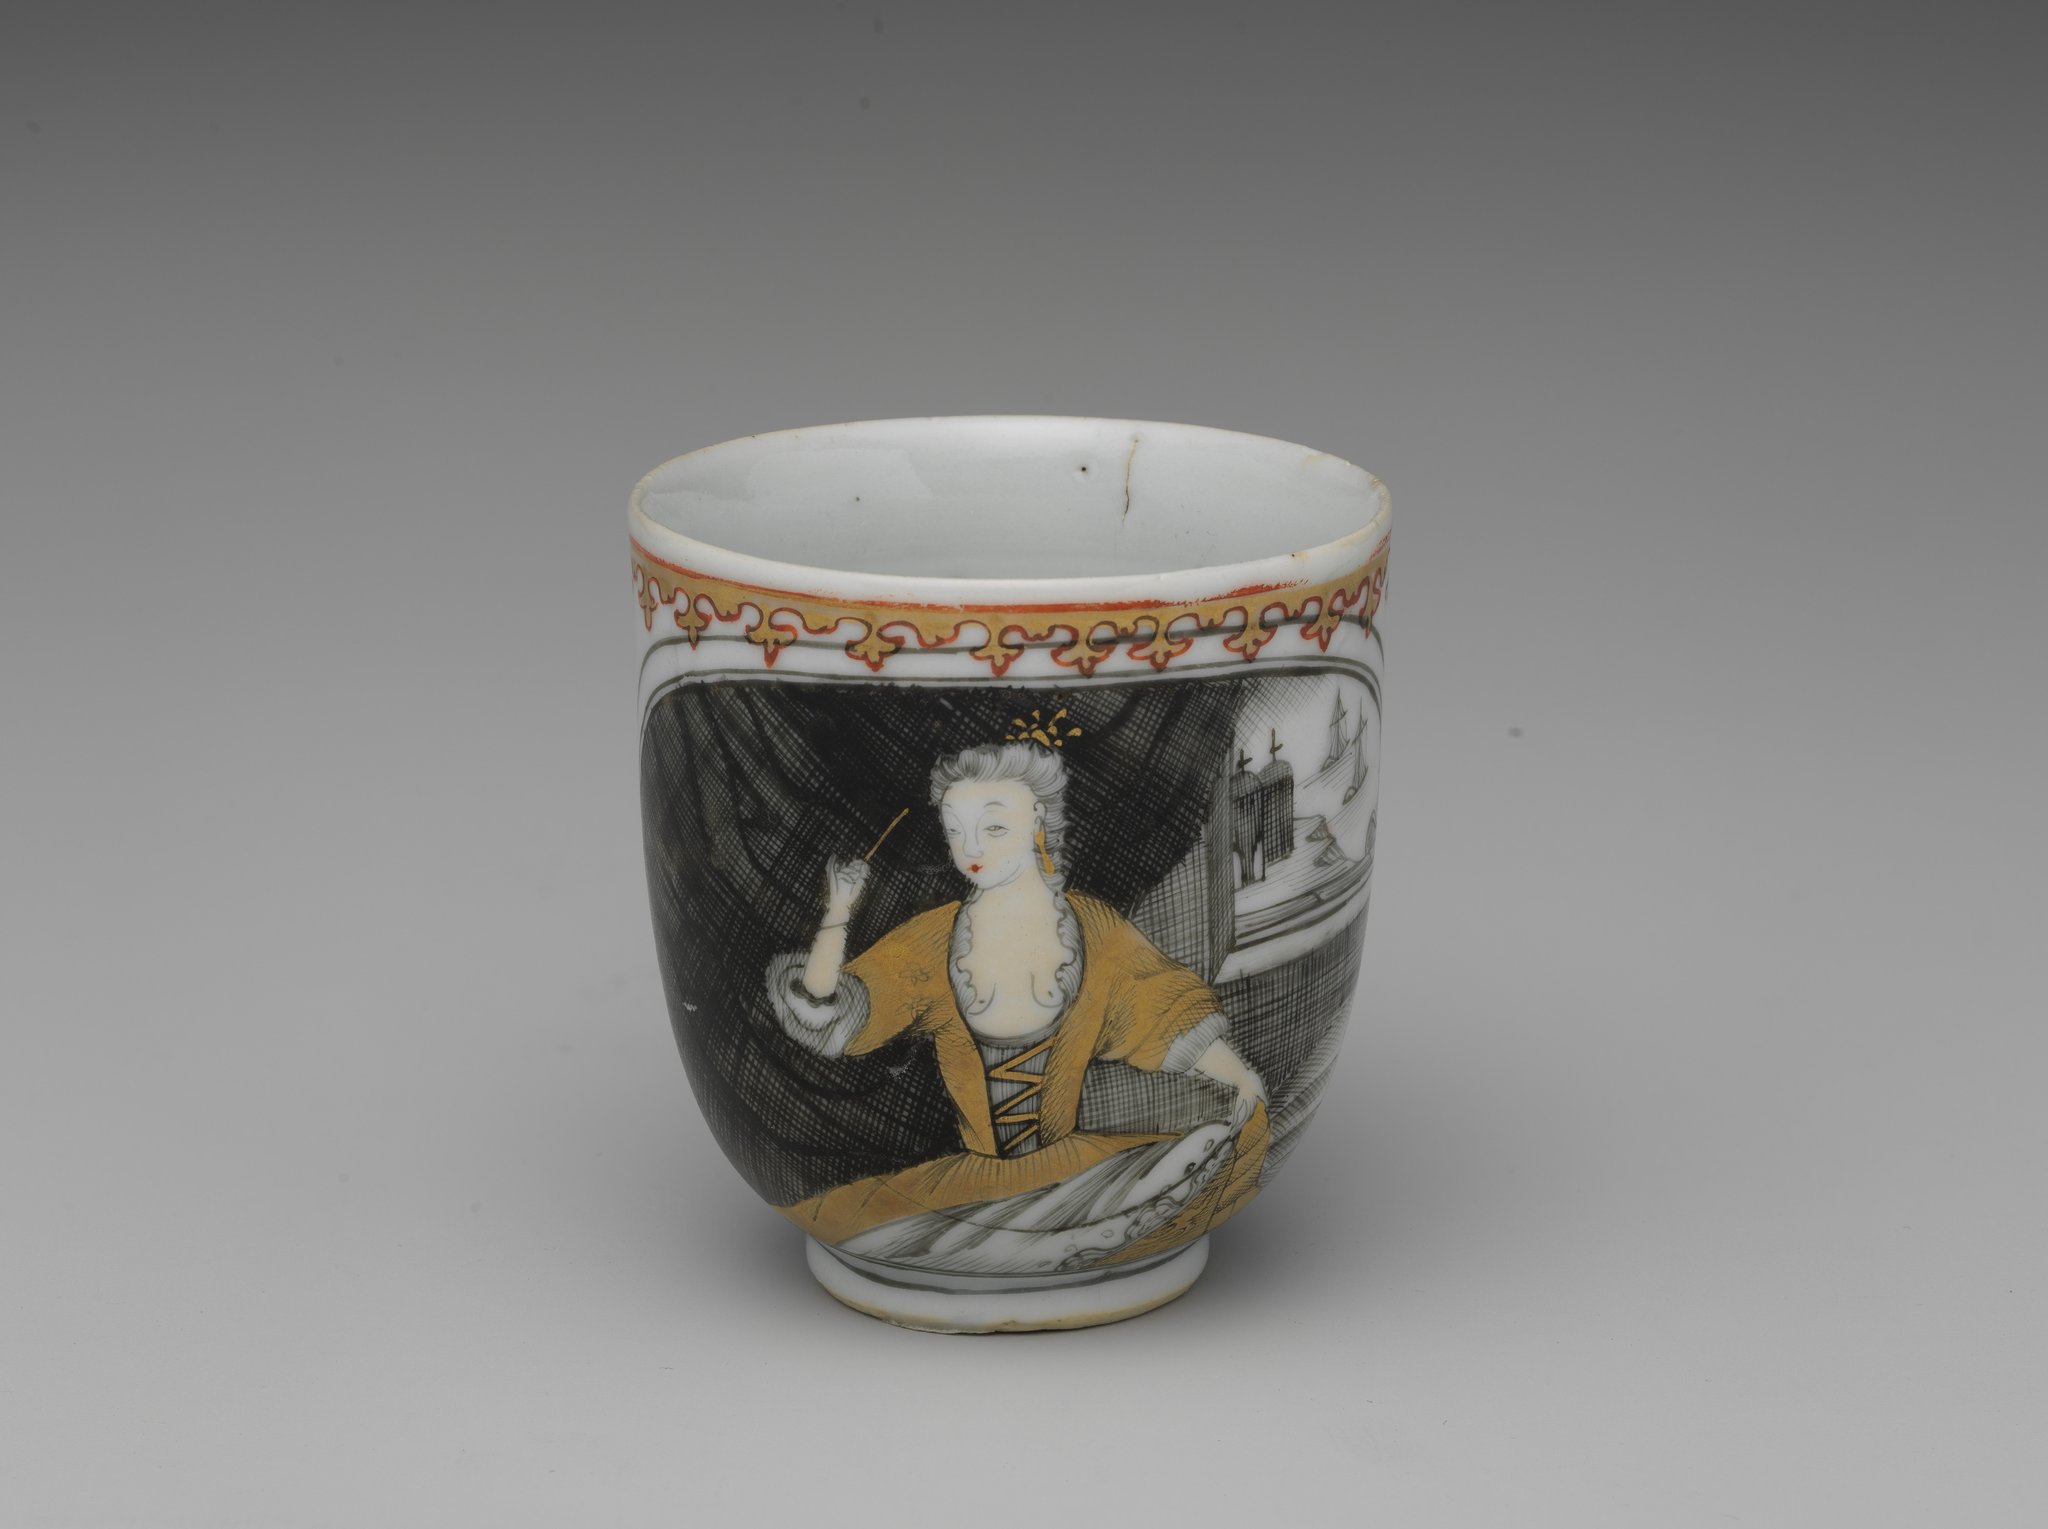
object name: cup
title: Cup (part of a service)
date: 1750-1770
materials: hard paste porcelain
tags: women,needlework,sewing